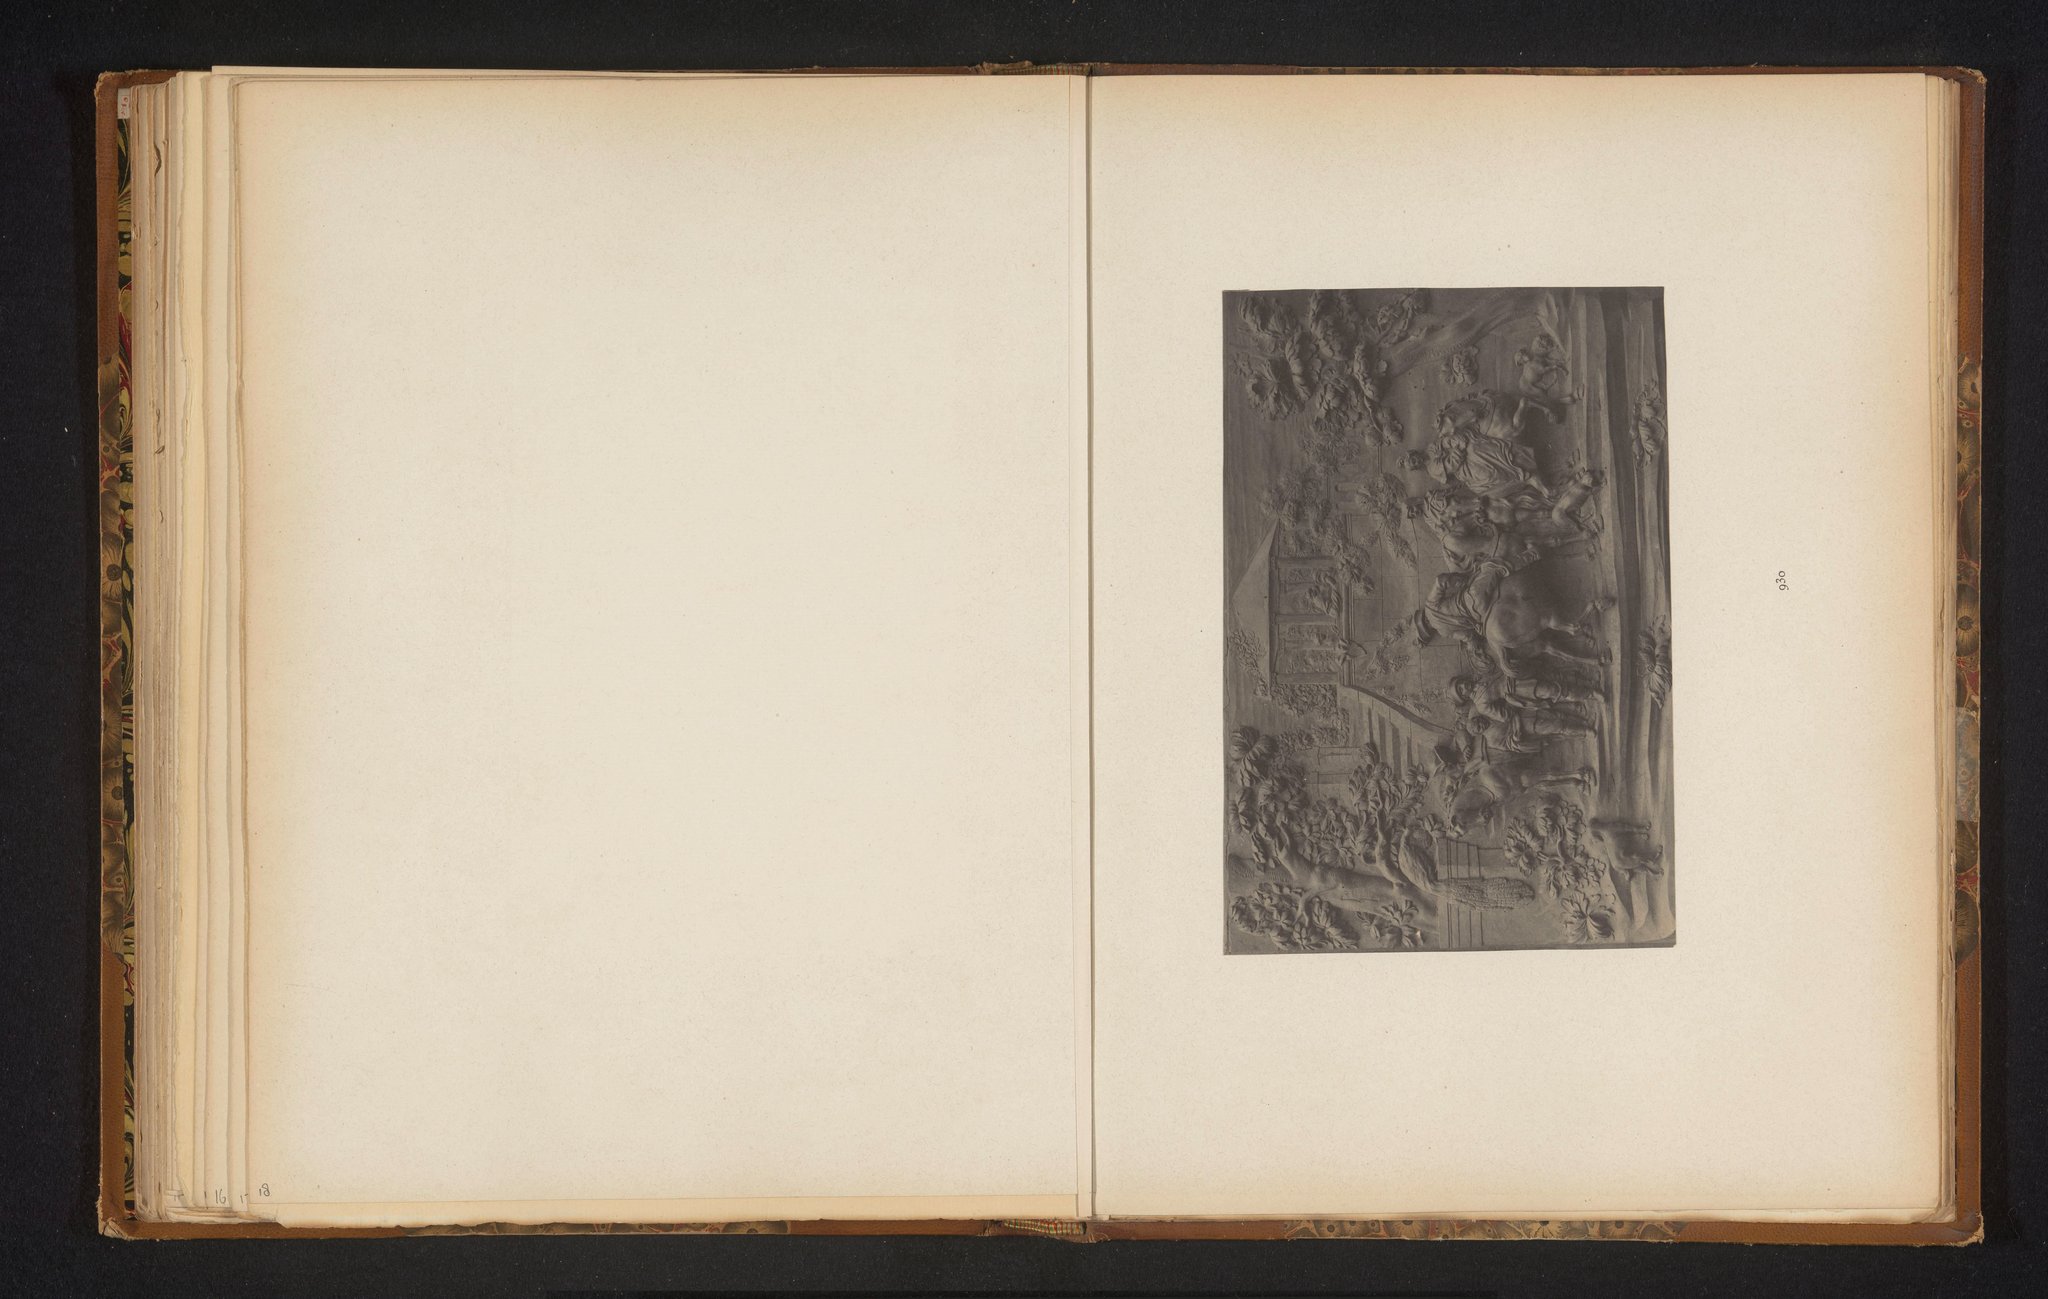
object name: photograph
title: Reliëf van de voorbereidingen van de jacht in hout gesneden uit de collectie van Antonin Terme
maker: Anonymous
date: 1880-1885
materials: photographic support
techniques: platinum process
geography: liège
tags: art collection, art gallery, hunting, chase, sculpture (+ relief ~ sculpture)